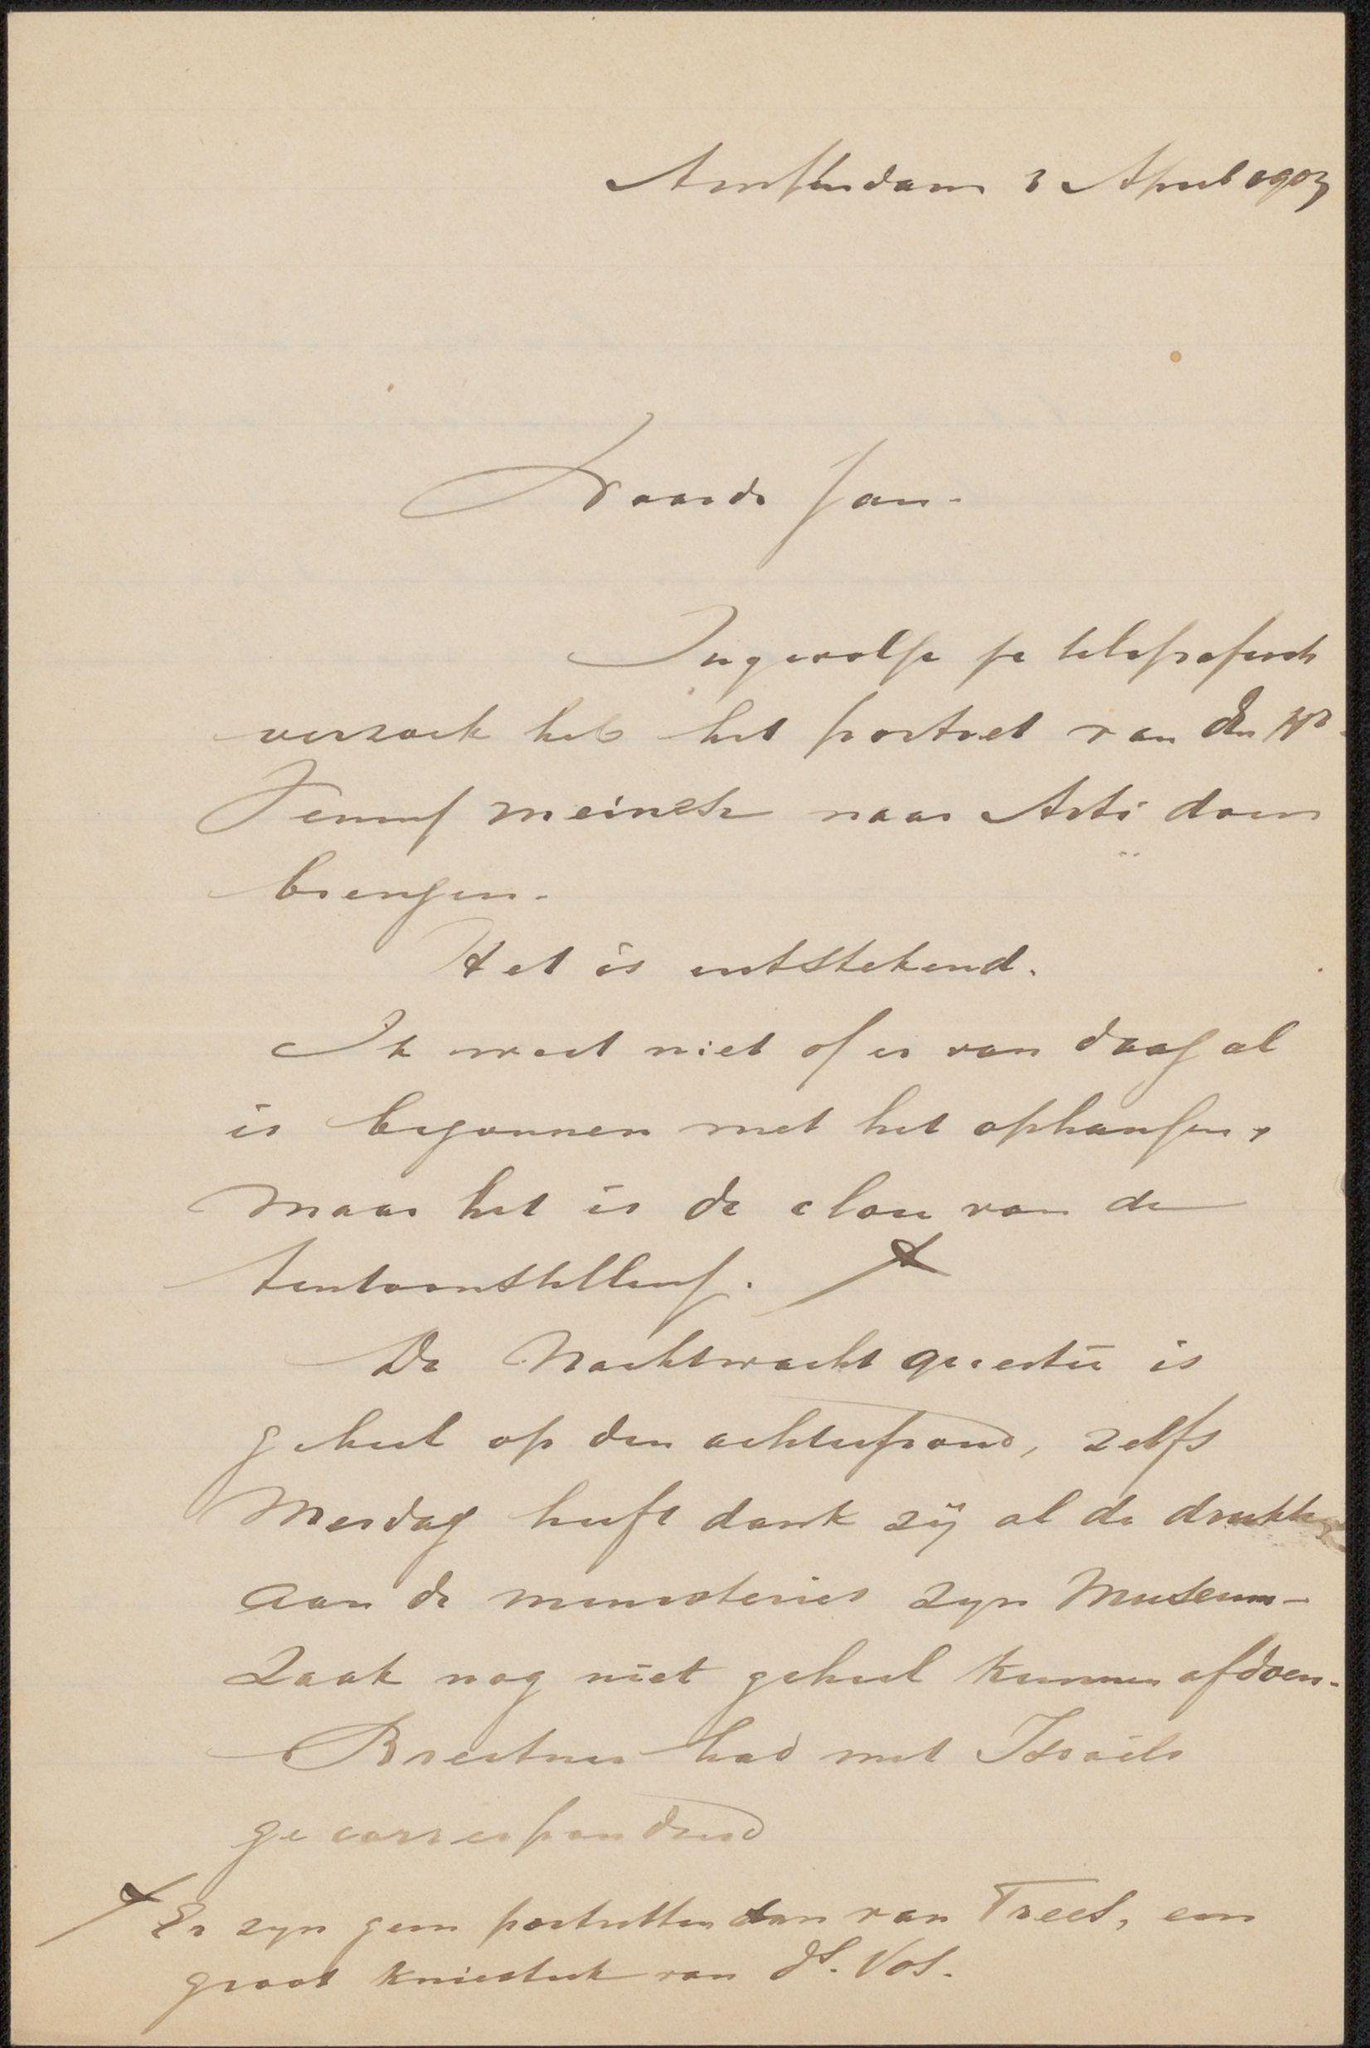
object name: letter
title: Brief aan Jan Veth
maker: cornelis gerardus t hooft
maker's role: draughtsman, painter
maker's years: 1866-1936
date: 1903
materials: ink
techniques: pen, writing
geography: amsterdam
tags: thérèse schwartze, rotterdam, george hendrik breitner, print maker, designer, jan veth, the hague, hendrik willem mesdag, antwerp, haarlem, frans hals, leiden, rembrandt van rijn, abraham bredius, anonymous historical person portrayed, exhibition ~ art, money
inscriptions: collector's mark: ‘RPK’